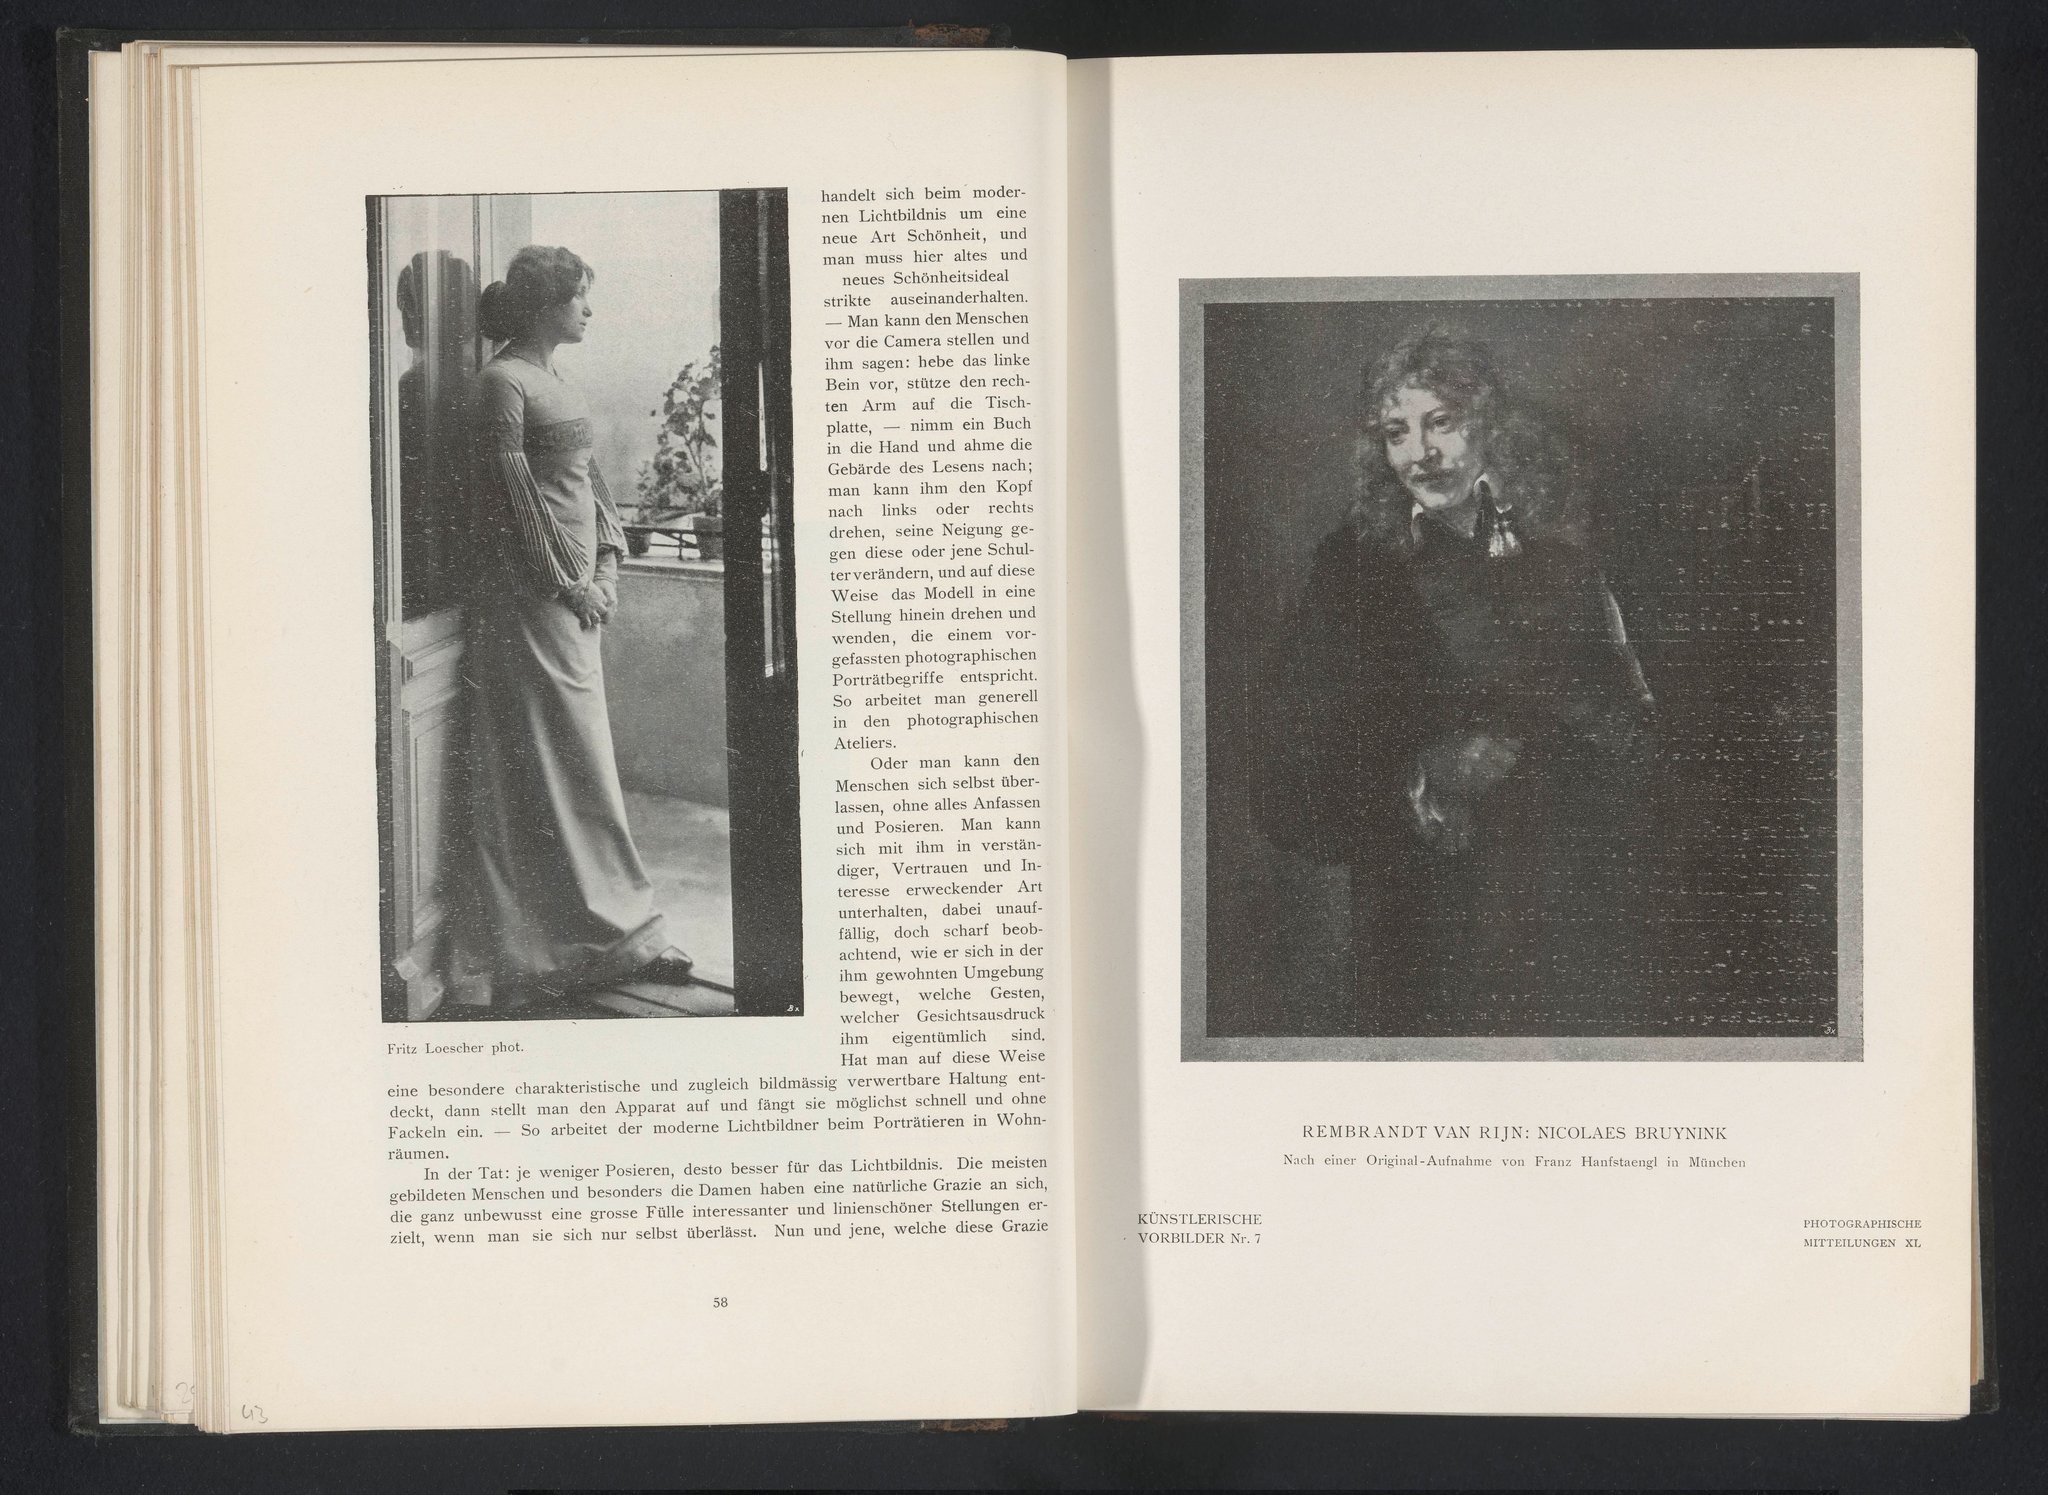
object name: page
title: Reproductie van een geschilderd portret van Nicolaas Bruyningh door Rembrandt van Rijn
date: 1898-1903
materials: paper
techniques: autotype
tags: historical persons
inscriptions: inscription: ‘Künstlerische Vorbilder Nr. 7/ Photographische Mitteilungen XL’, monogram: ‘BX’, inscription: ‘Nach einer Original-Aufnahme von Franz Hanfstaengl in München’